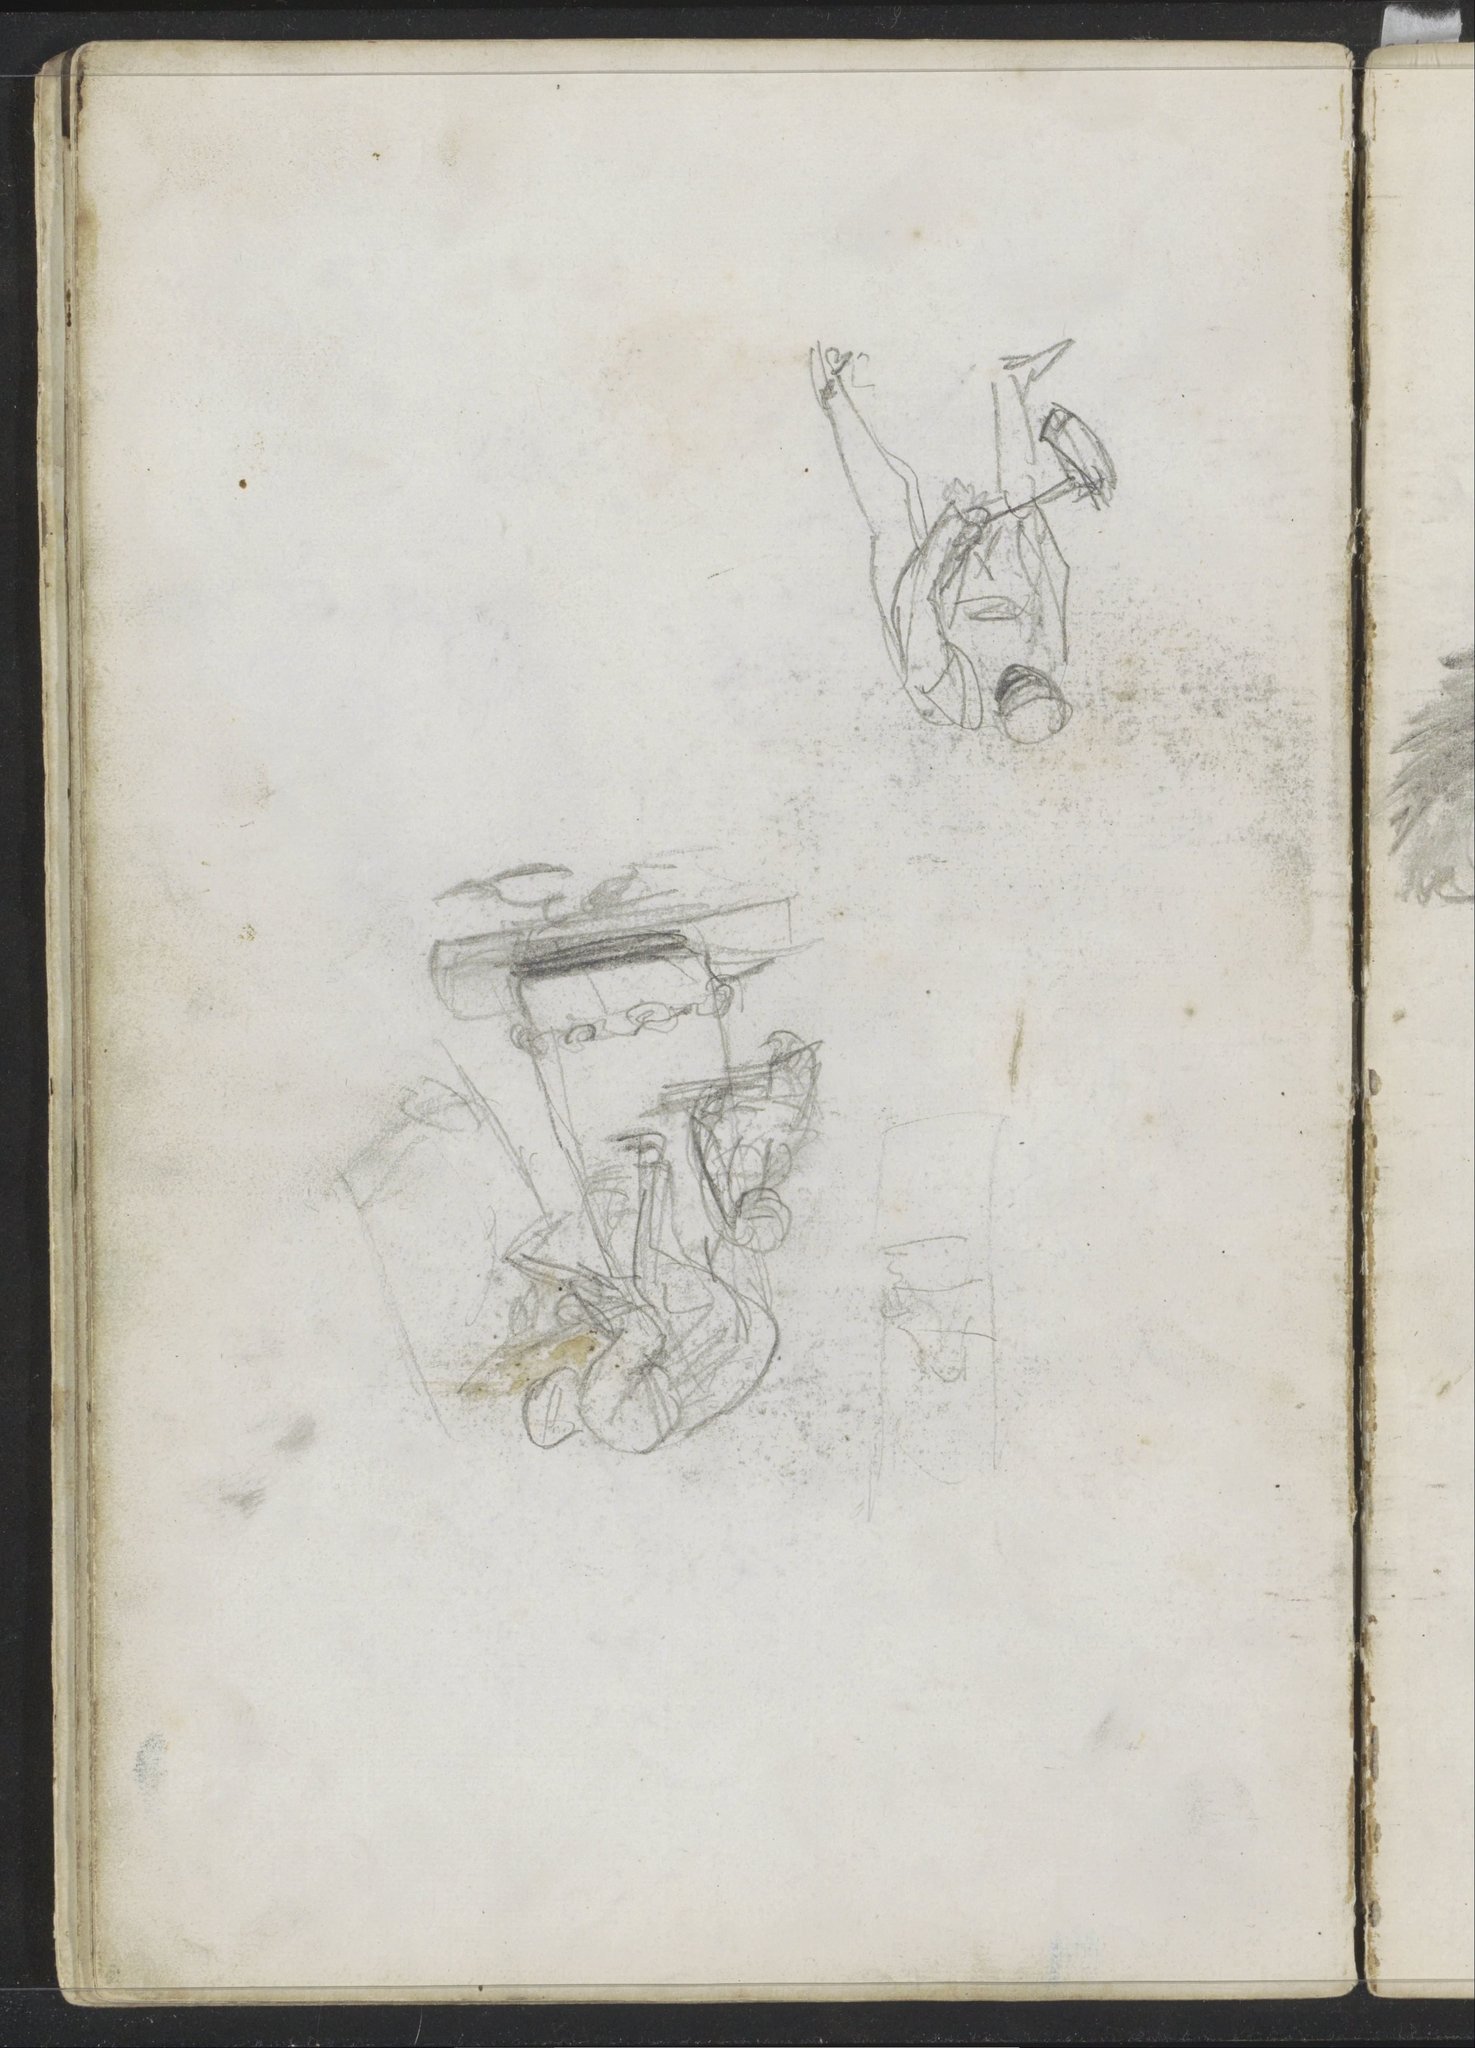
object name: sketchbook leaf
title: Bukkende man met een bijl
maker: jozef israëls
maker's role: draughtsman, painter, print maker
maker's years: 1824-1911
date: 1855-1859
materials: paper, pencil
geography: zandvoort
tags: bending figure (+ male human being (not to be used where -a- is prescribed)), tools, aids, implements ~ crafts and industries: axe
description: Tevens een figuurstudie. Blad 16 verso uit een schetsboek met 22 bladen.